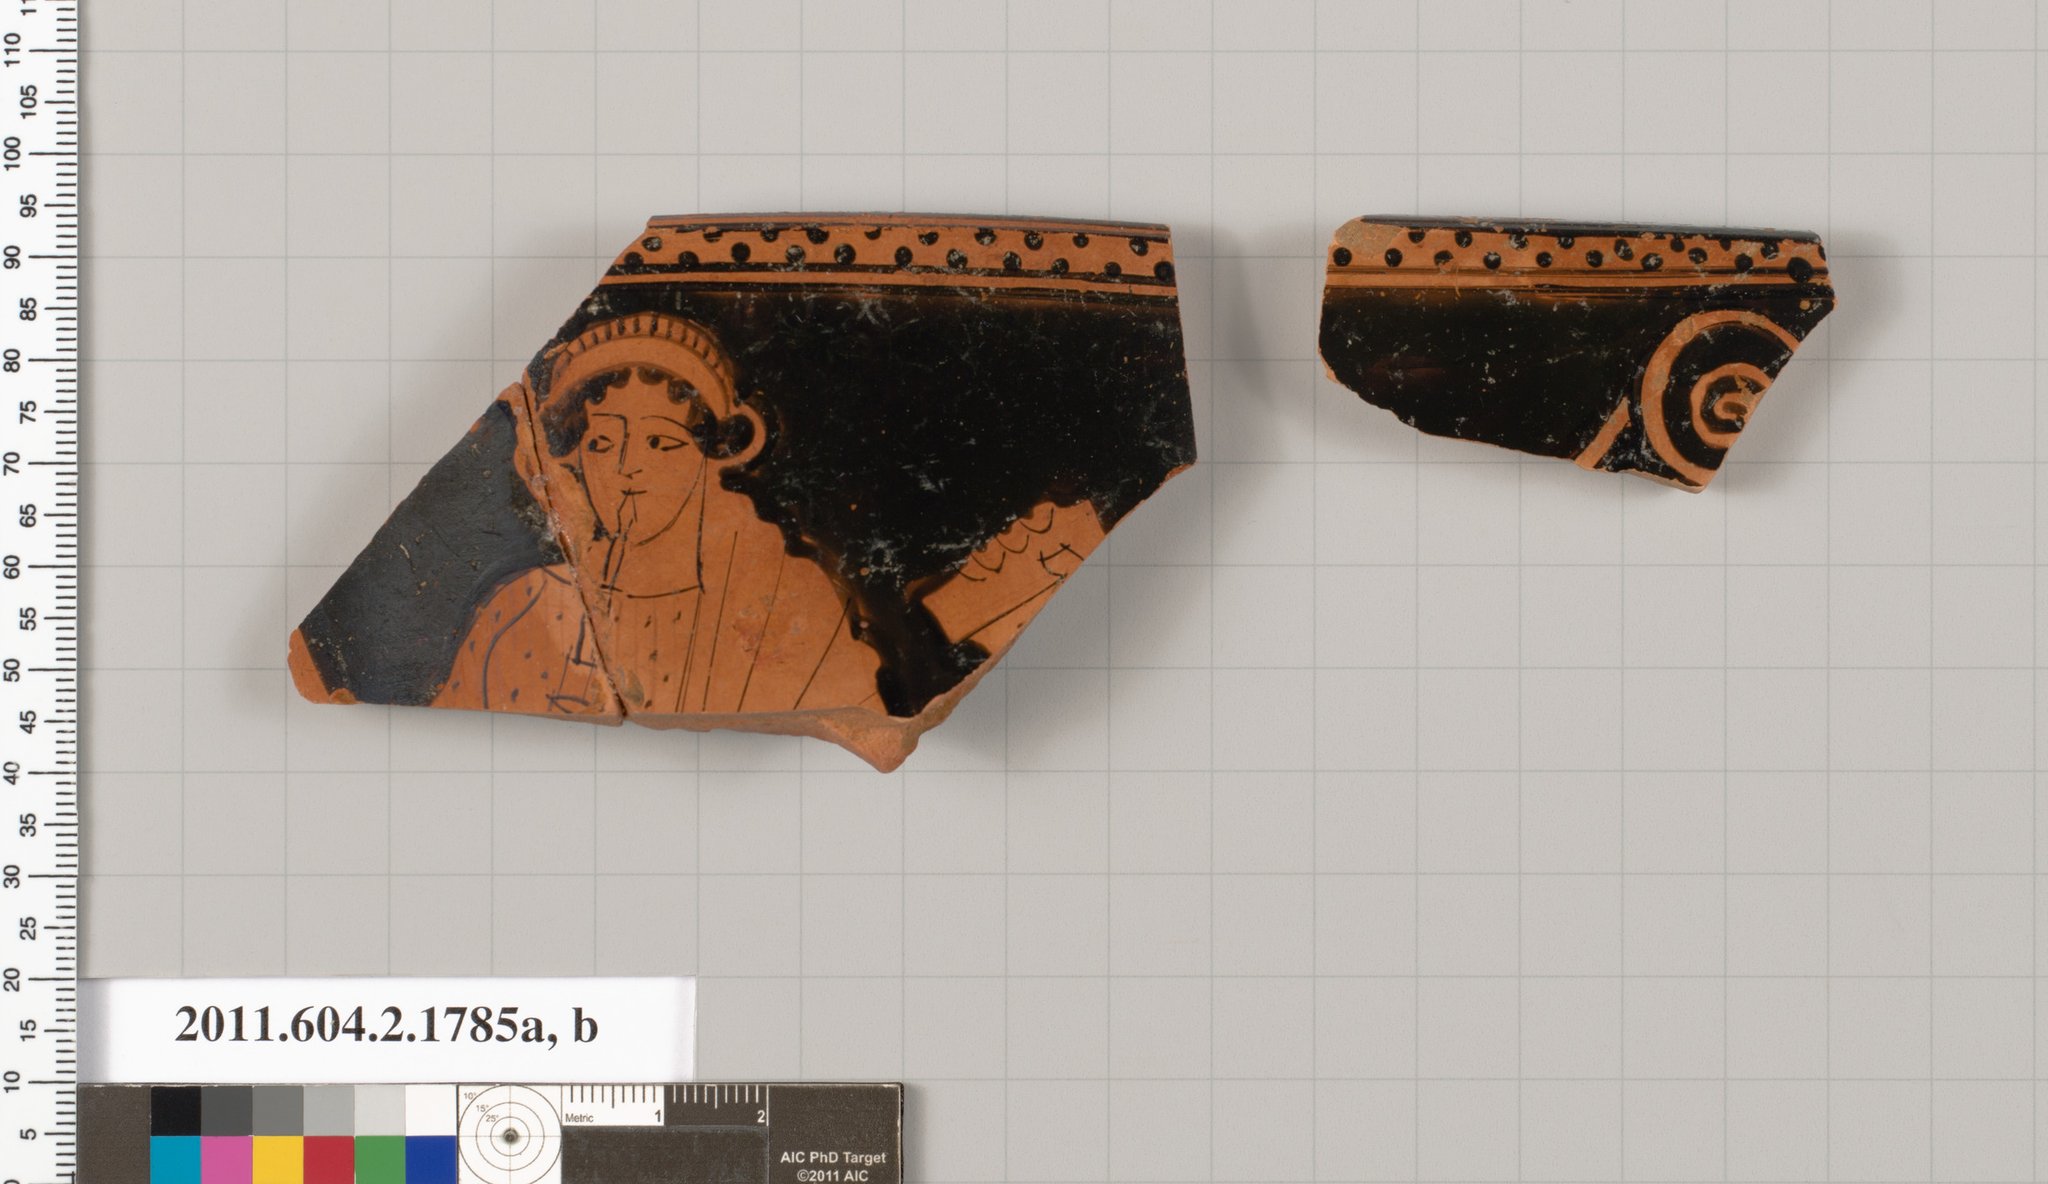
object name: skyphos fragment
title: Terracotta rim fragments of a skyphos (deep drinking cup)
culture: greek, attic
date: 475-451 BCE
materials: terracotta